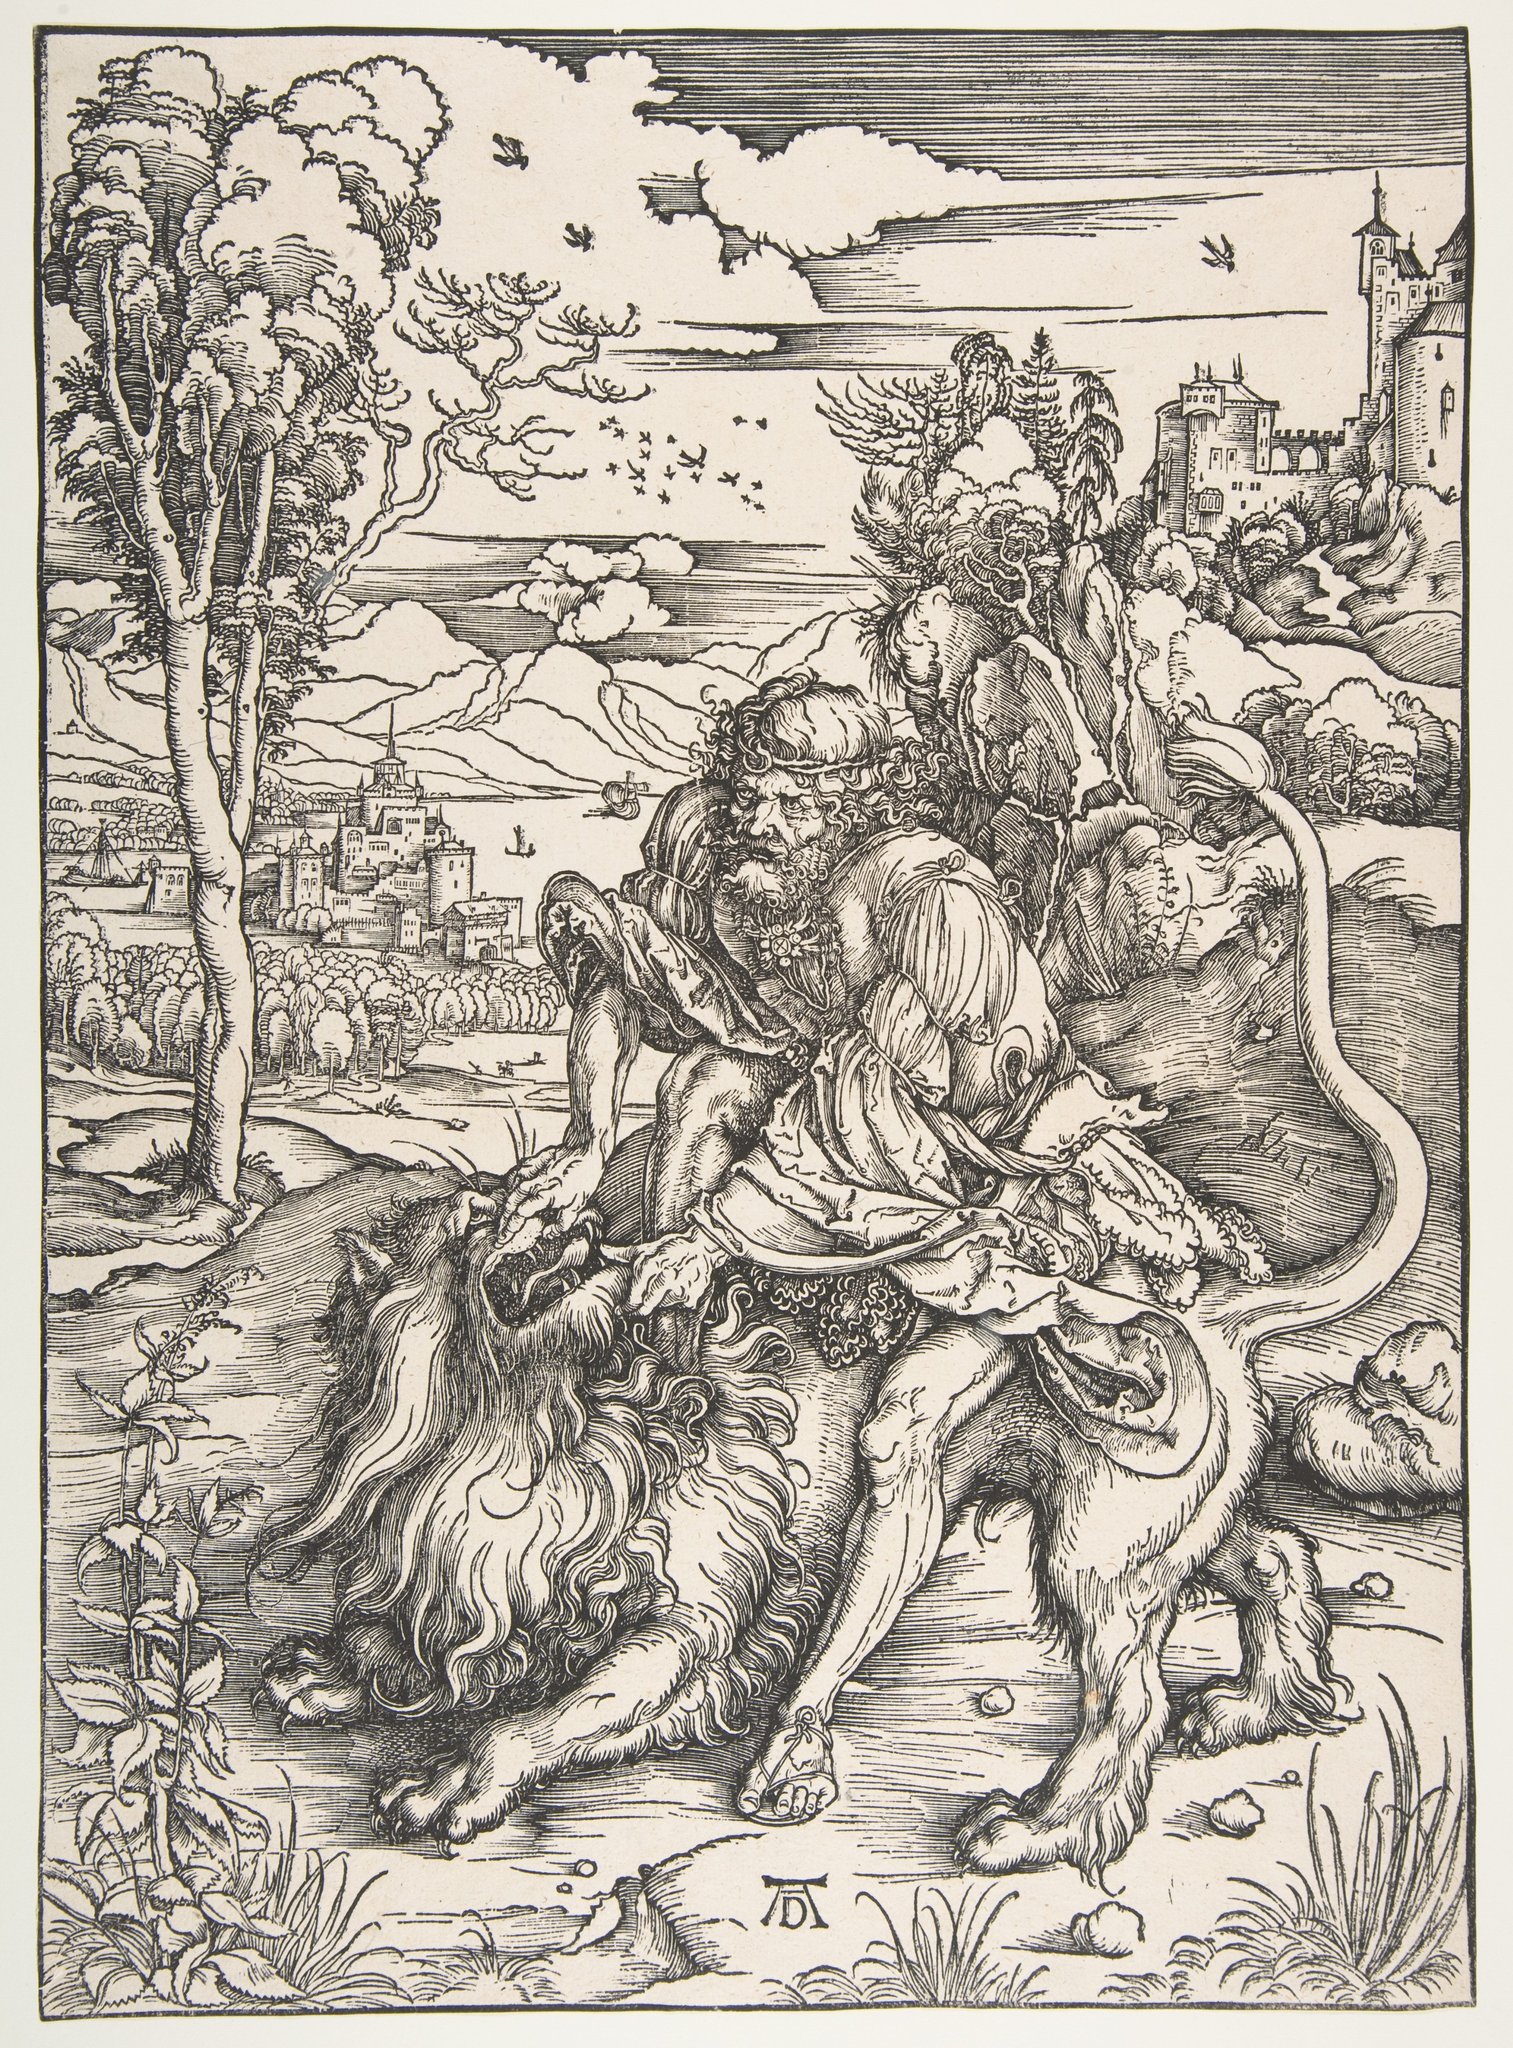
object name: print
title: Samson Rending the Lion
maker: albrecht dürer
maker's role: artist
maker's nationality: german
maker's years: 1471-1528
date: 1497-1498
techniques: woodcut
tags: lions,samson